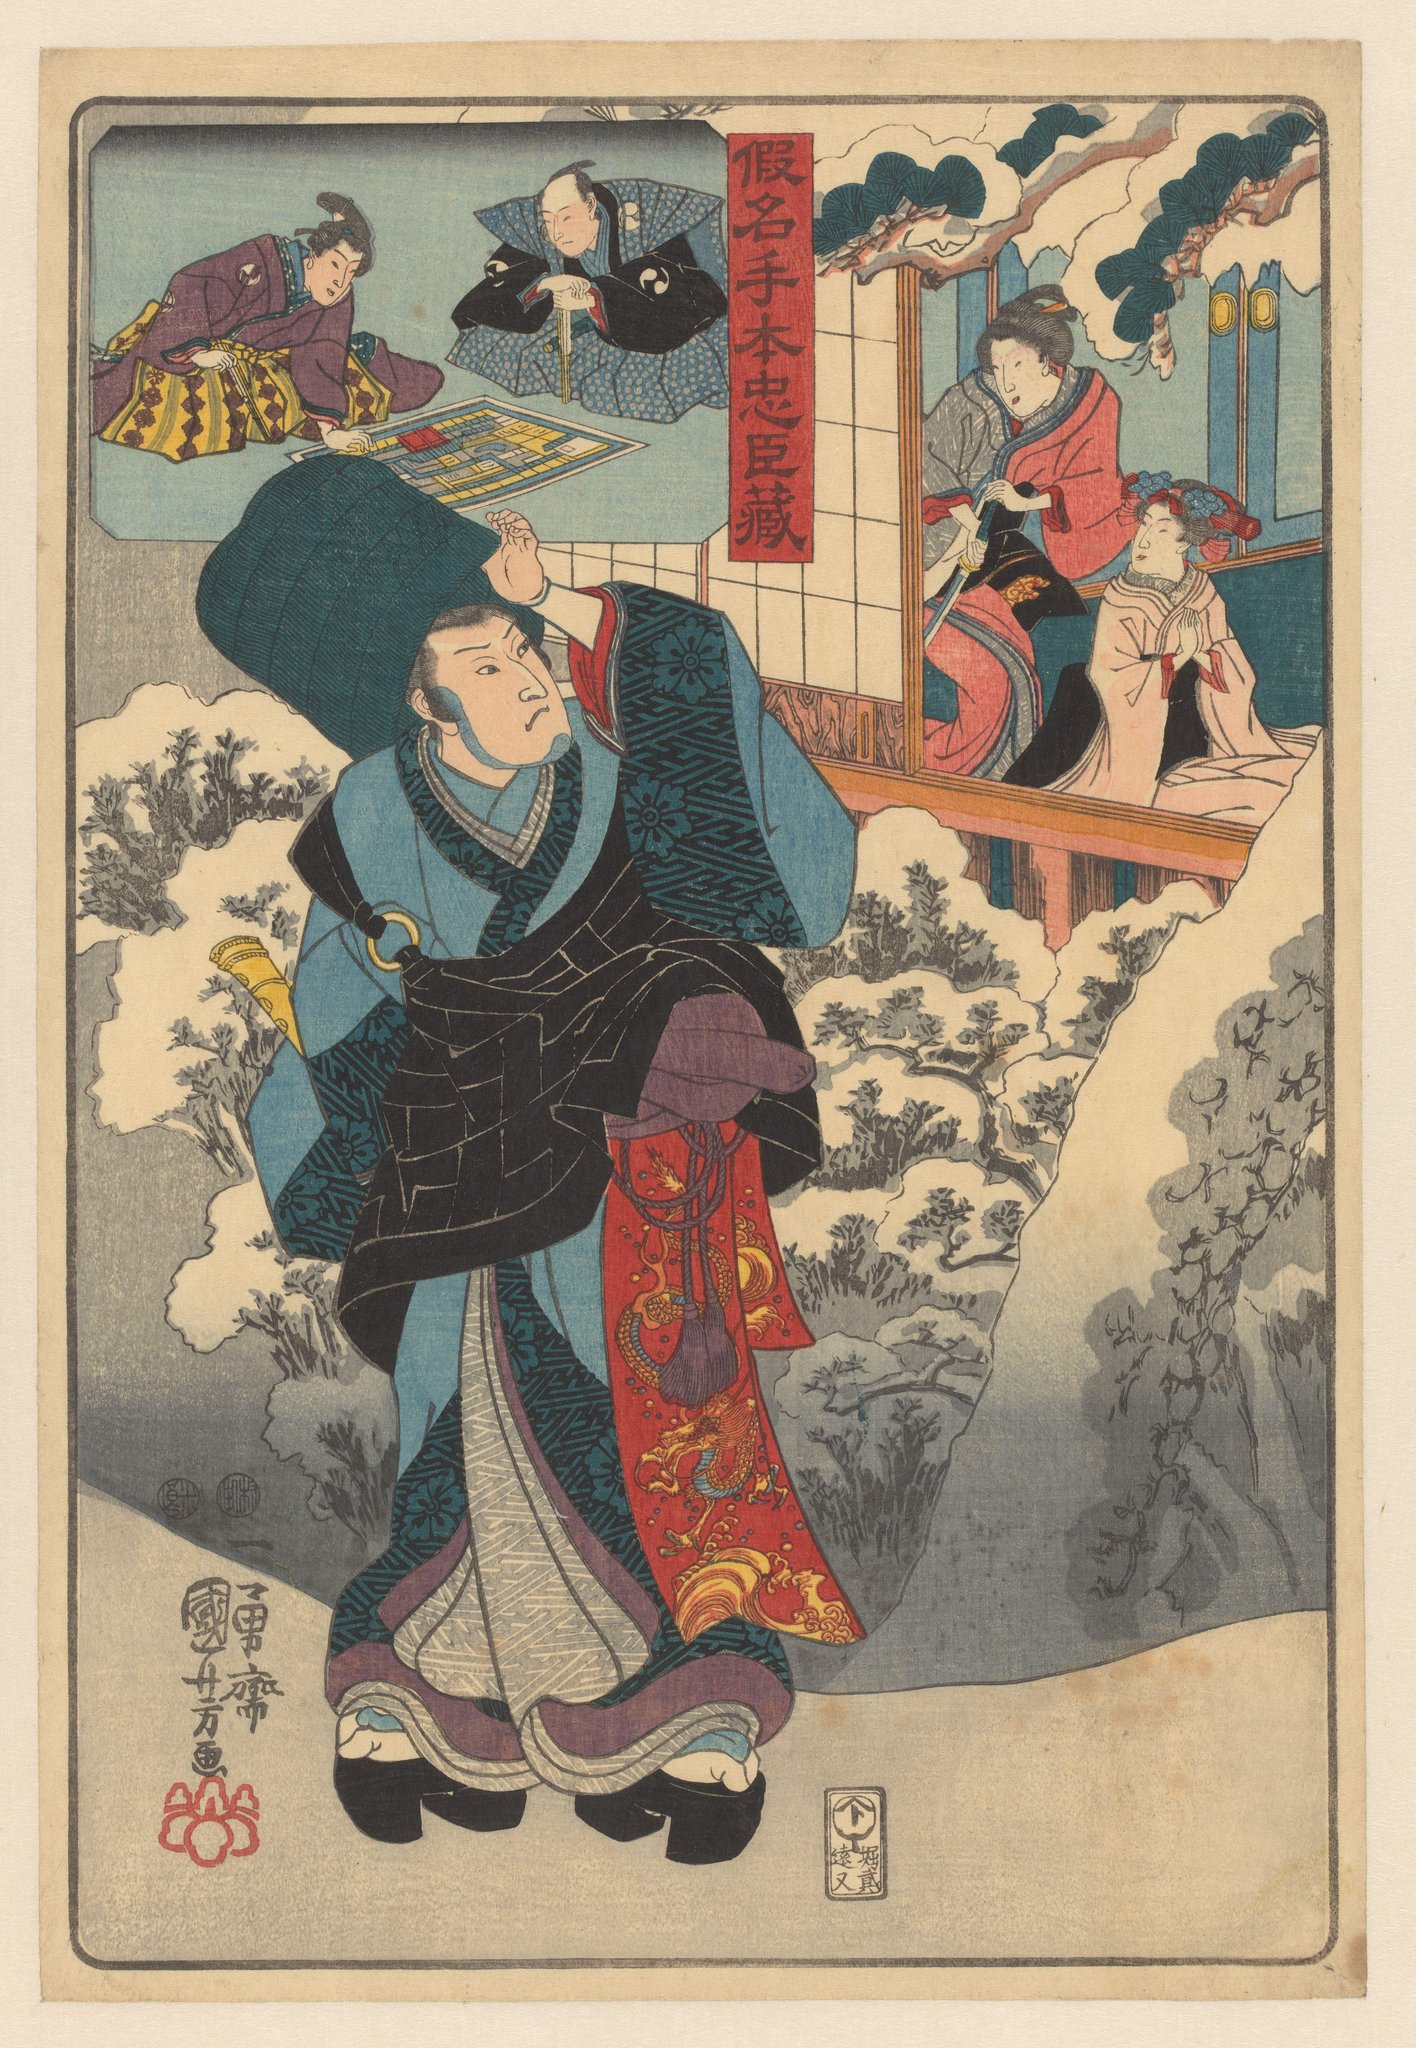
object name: print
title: Kanadehon chûshingura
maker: utagawa kuniyoshi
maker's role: draughtsman, print maker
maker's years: 1798-1861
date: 1847-1850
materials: paper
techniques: woodcut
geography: japan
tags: adult man, housing, snow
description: In een sneeuwlandschap schuift de als reizende monnik vermomde Honzô zijn groene hoed omhoog, terwijl hij in de richting van een kamer kijkt waarin een vrouw en meisje zitten. De vrouw stond op het punt het meisje met een zwaard te onthoofden, wanneer ze door het geluid van een fluit gestopt wordt. De fluit werd bespeeld door de monnik, die in werkelijkheid haar eigen man is. Scene uit de negende akte van het kabuki toneelstuk Kanadehon chûshingura, waarbij de man gespeeld wordt door acteur Sawamura Chôjûrô V.